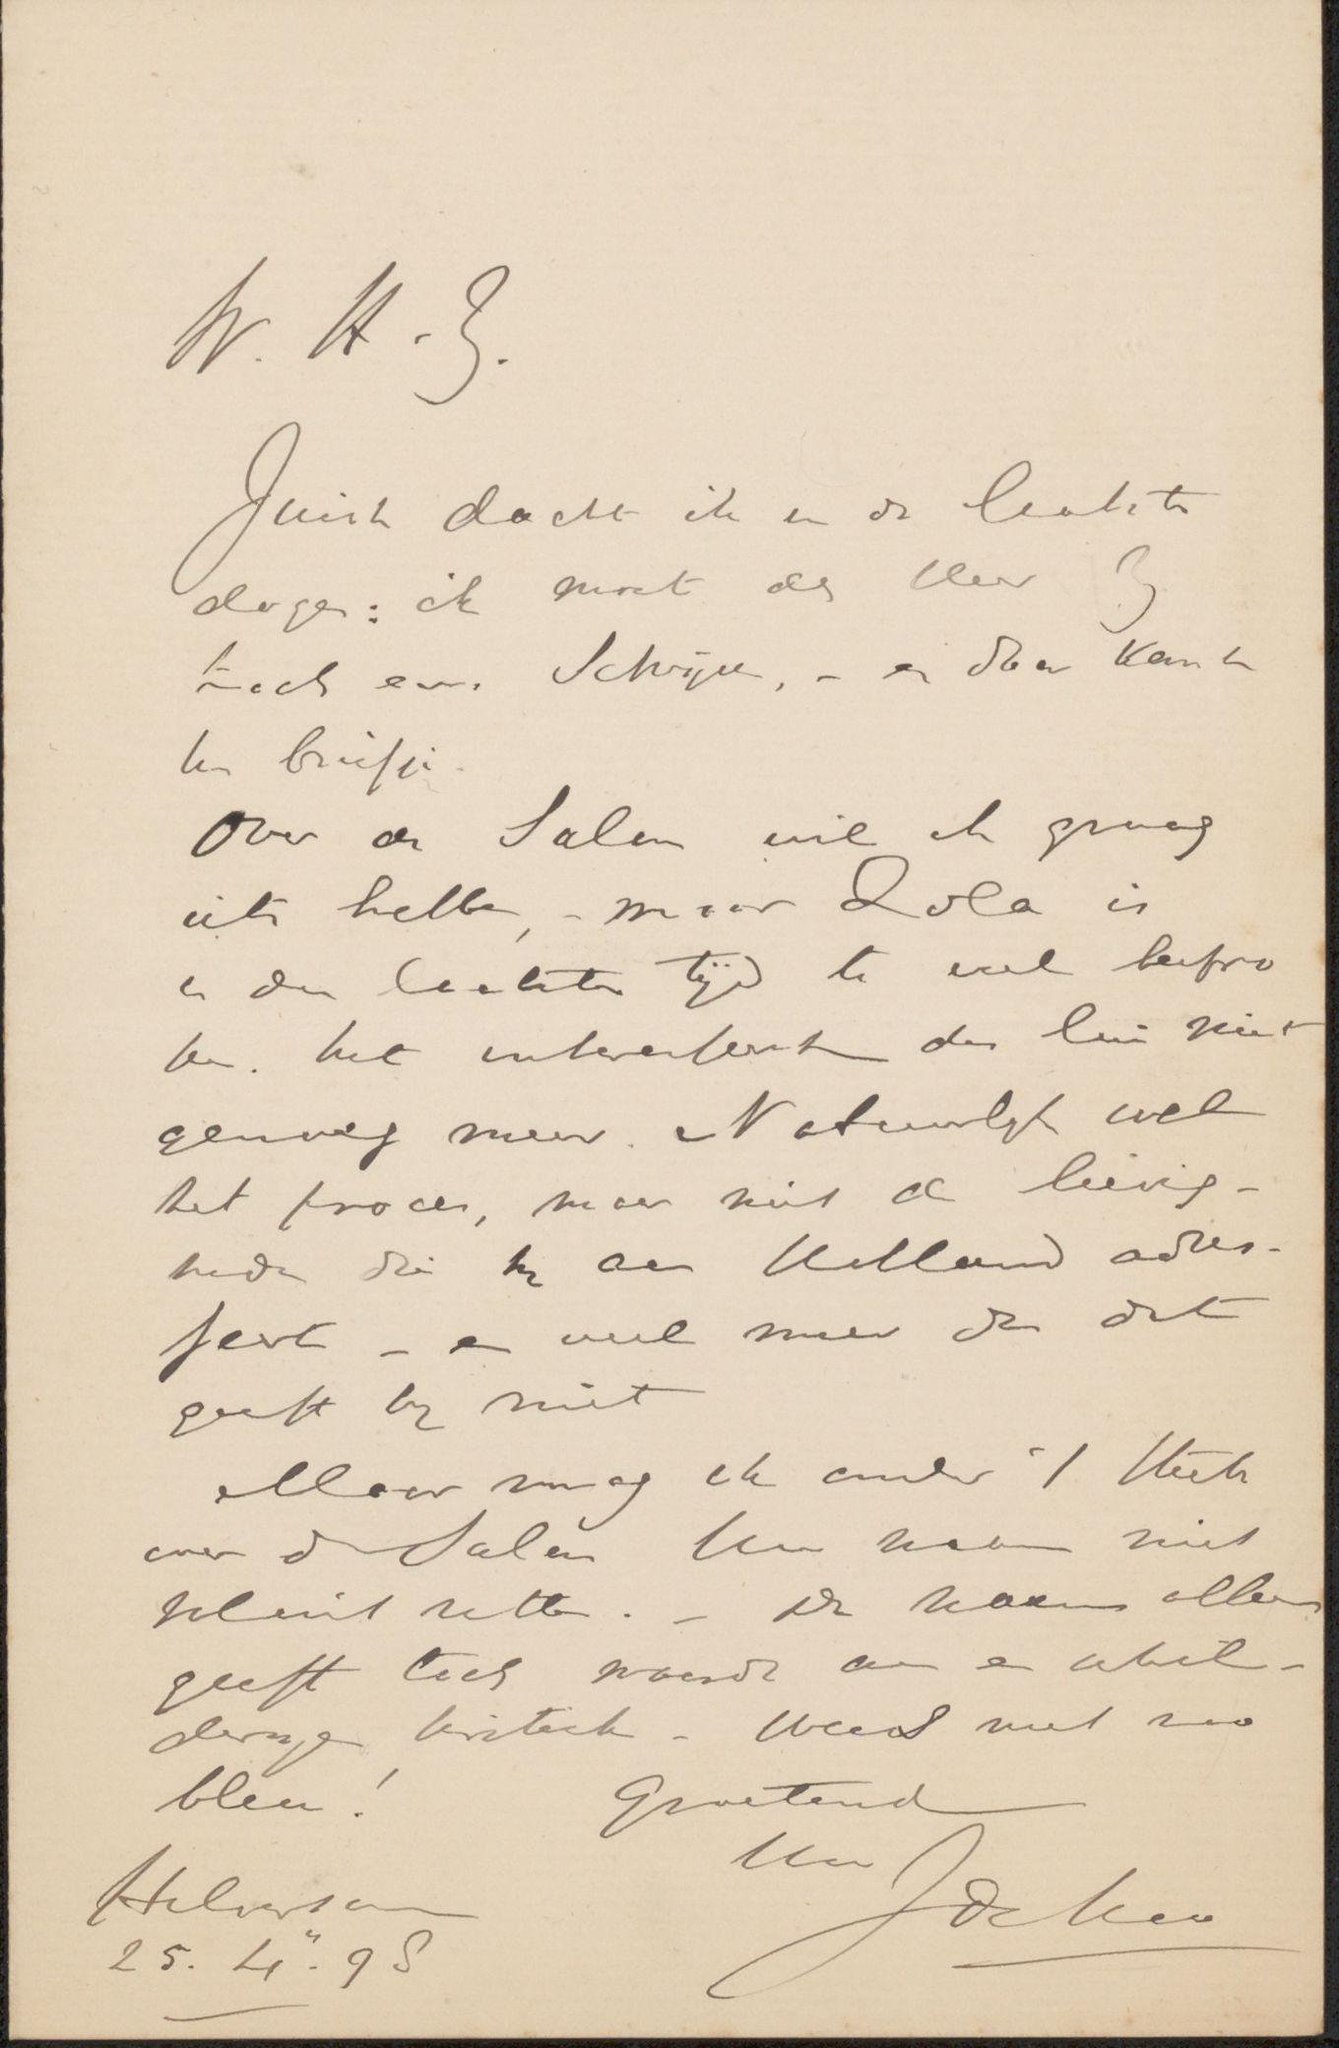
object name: letter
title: Brief aan Philip Zilcken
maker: johannes de koo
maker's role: auteur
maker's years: 1841-1909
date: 1898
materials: ink, paper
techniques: pen, writing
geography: hilversum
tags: paris, emile zola, the hague, painter, draughtsman, philip zilcken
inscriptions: collector's mark: ‘RPK’